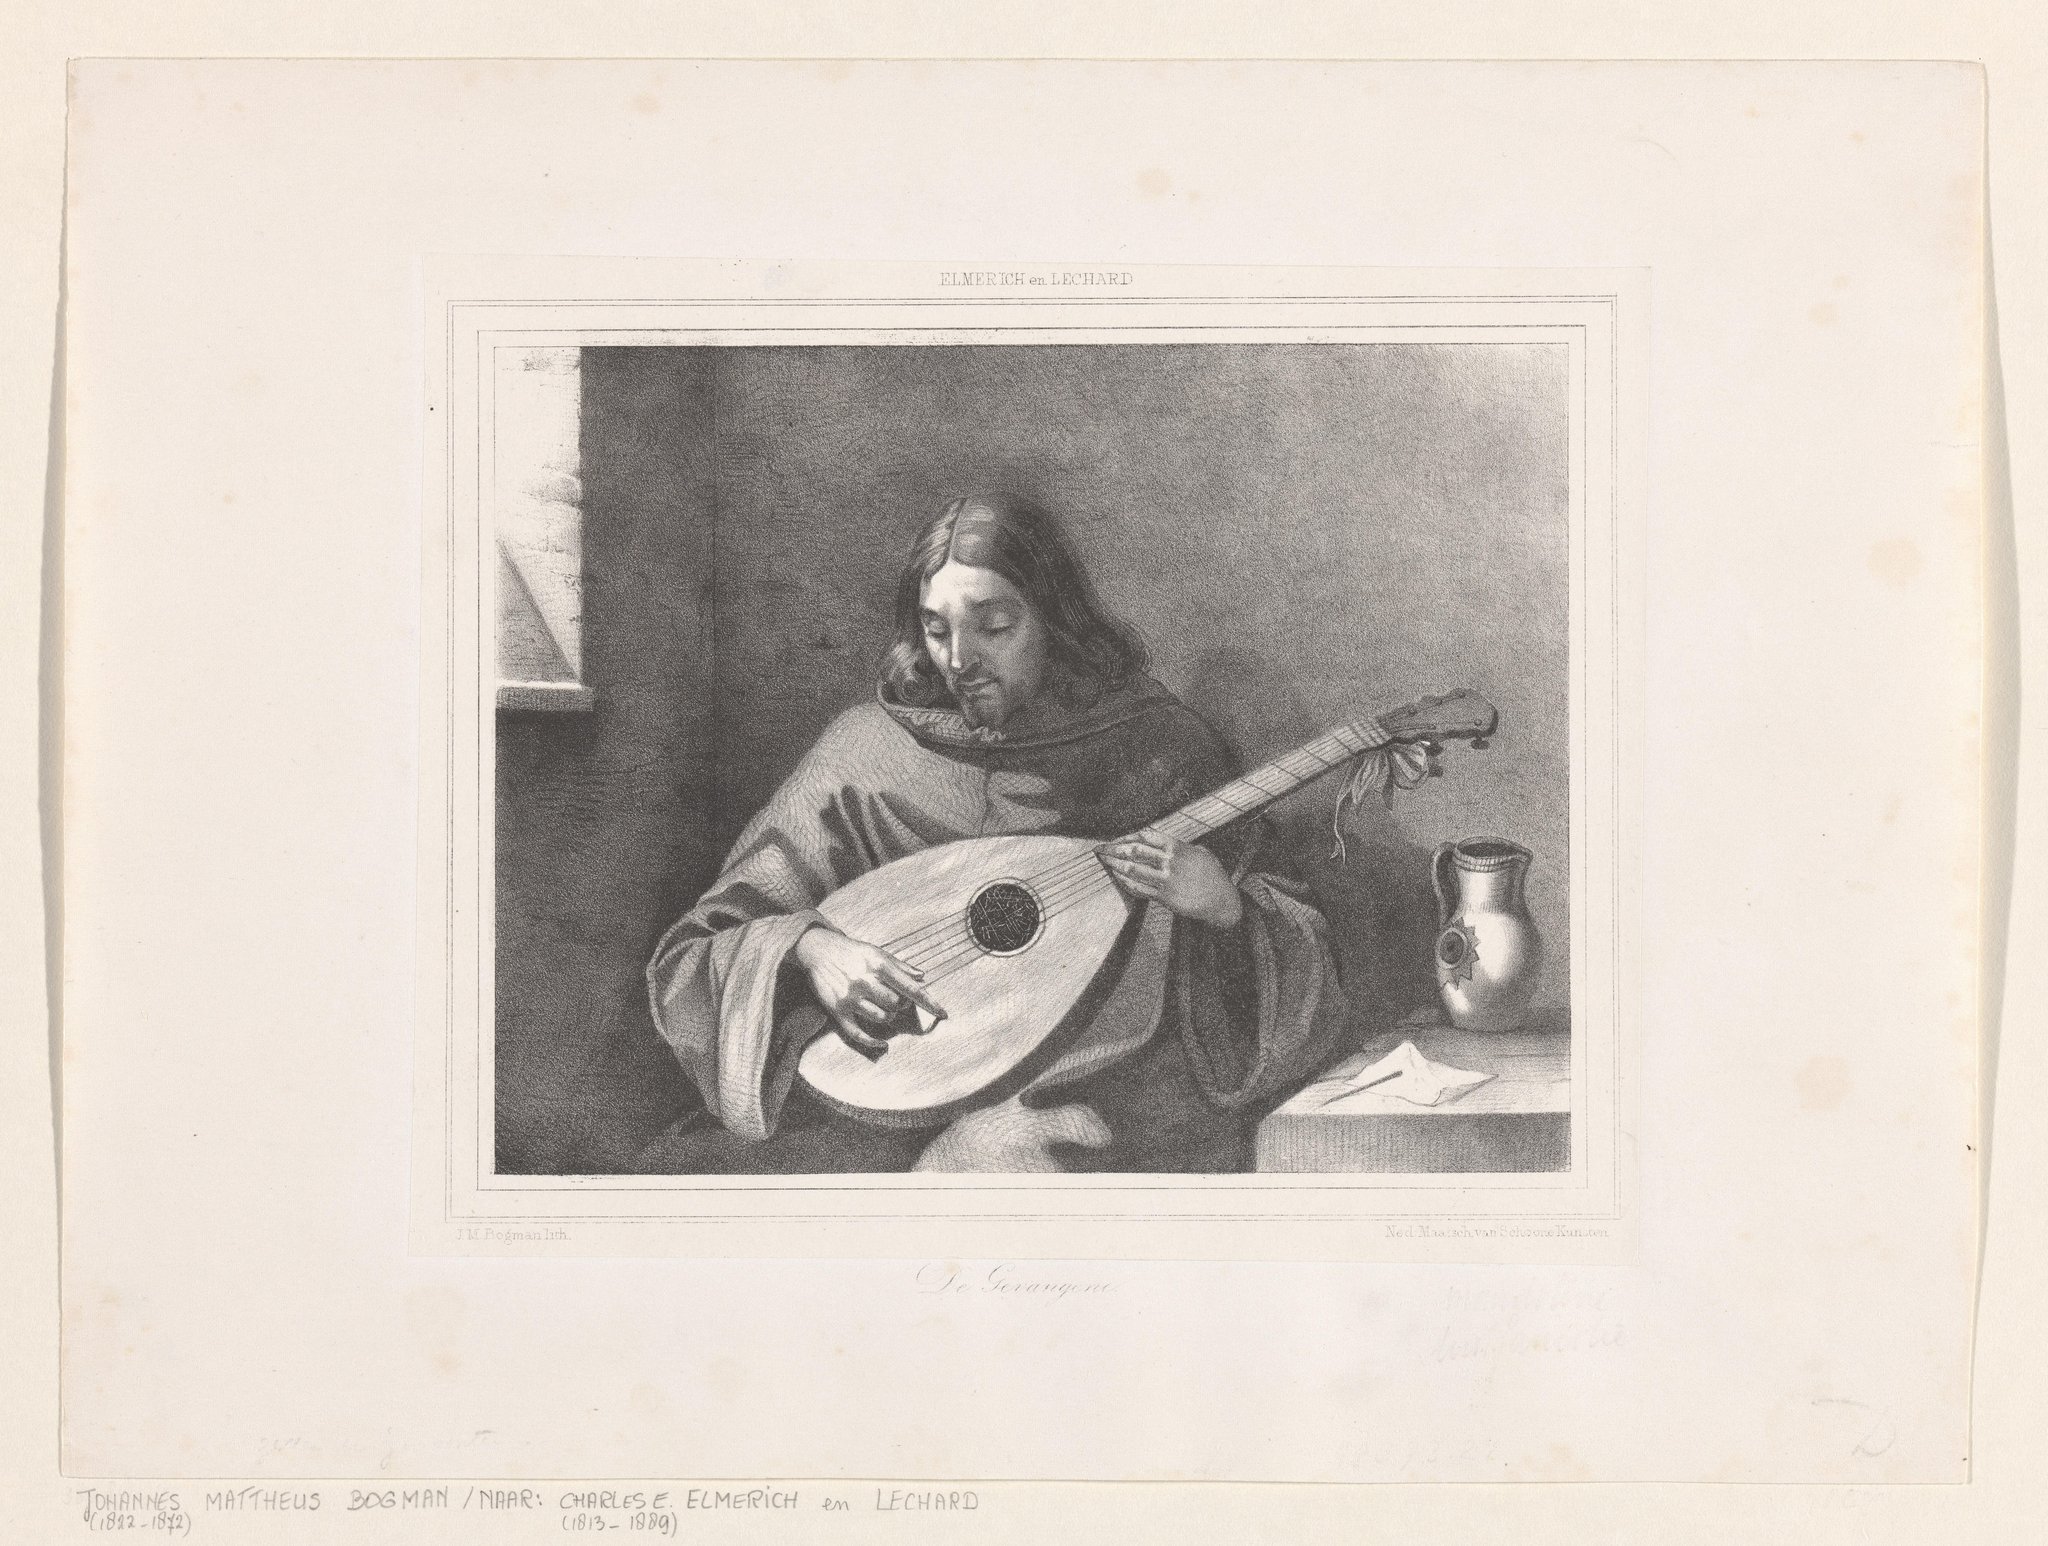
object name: print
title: Gitaarspelende gevangene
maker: johannes mattheus bogman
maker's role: print maker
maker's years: 1822-1872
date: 1840-1843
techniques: printmaking, lithograph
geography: the hague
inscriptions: stamp: ‘waller’ Lugt 2760, stamp: Lugt 2228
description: De man zit rechts van een raam. Op de tafel naast hem ligt een vel papier met een potlood, daarachter staat een kruik.